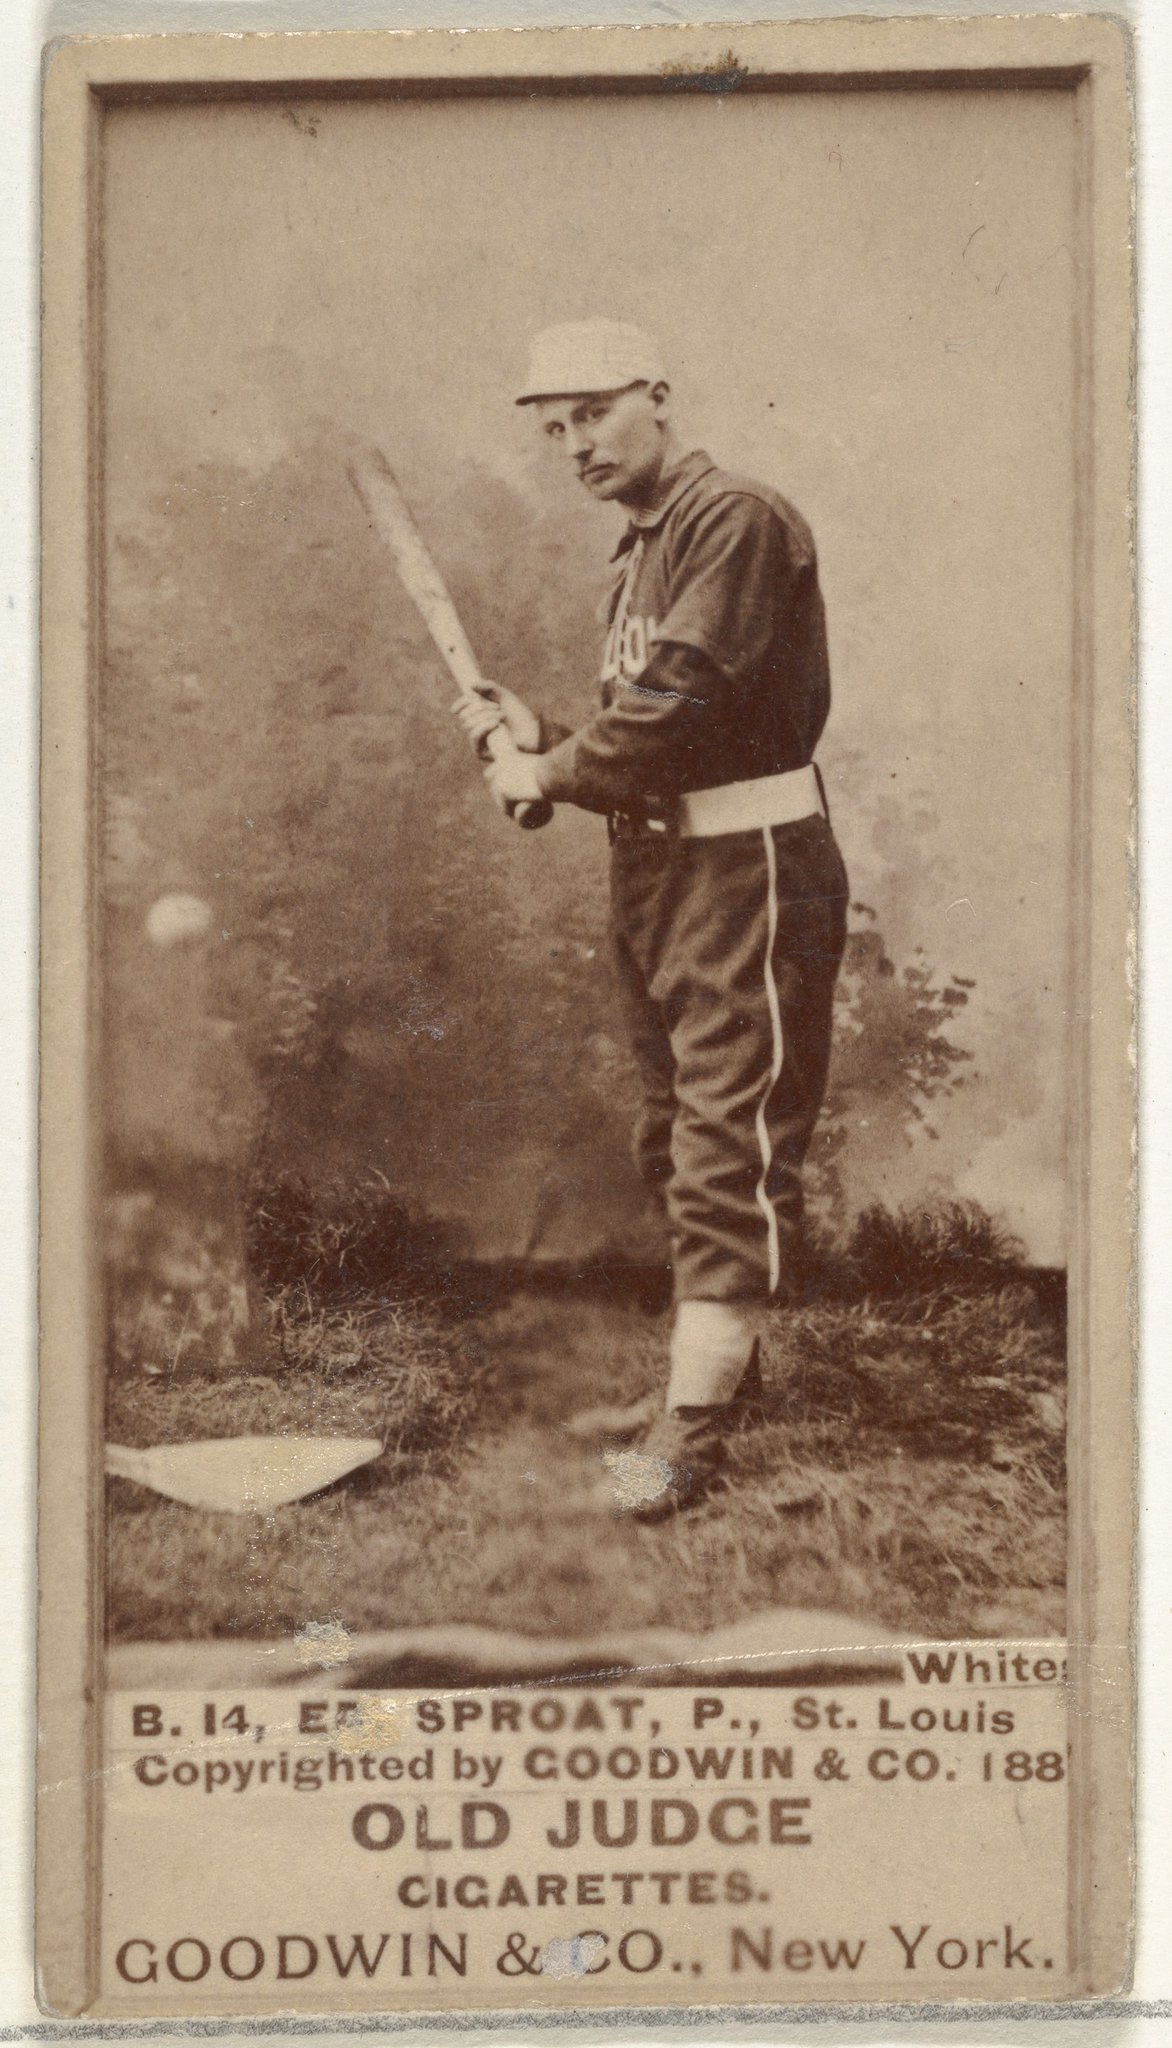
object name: baseball card, photograph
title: Sproat, Pitcher, St. Louis Whites, from the Old Judge series (N172) for Old Judge Cigarettes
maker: goodwin & company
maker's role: publisher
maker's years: 1850-1950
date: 1887-1889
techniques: albumen silver print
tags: men,portraits,baseball,athletes